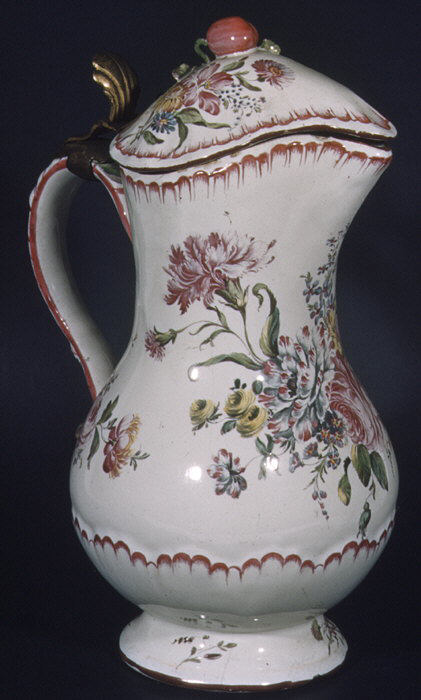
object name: jug with cover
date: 1753-1795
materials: faience, metal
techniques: glazing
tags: flowers